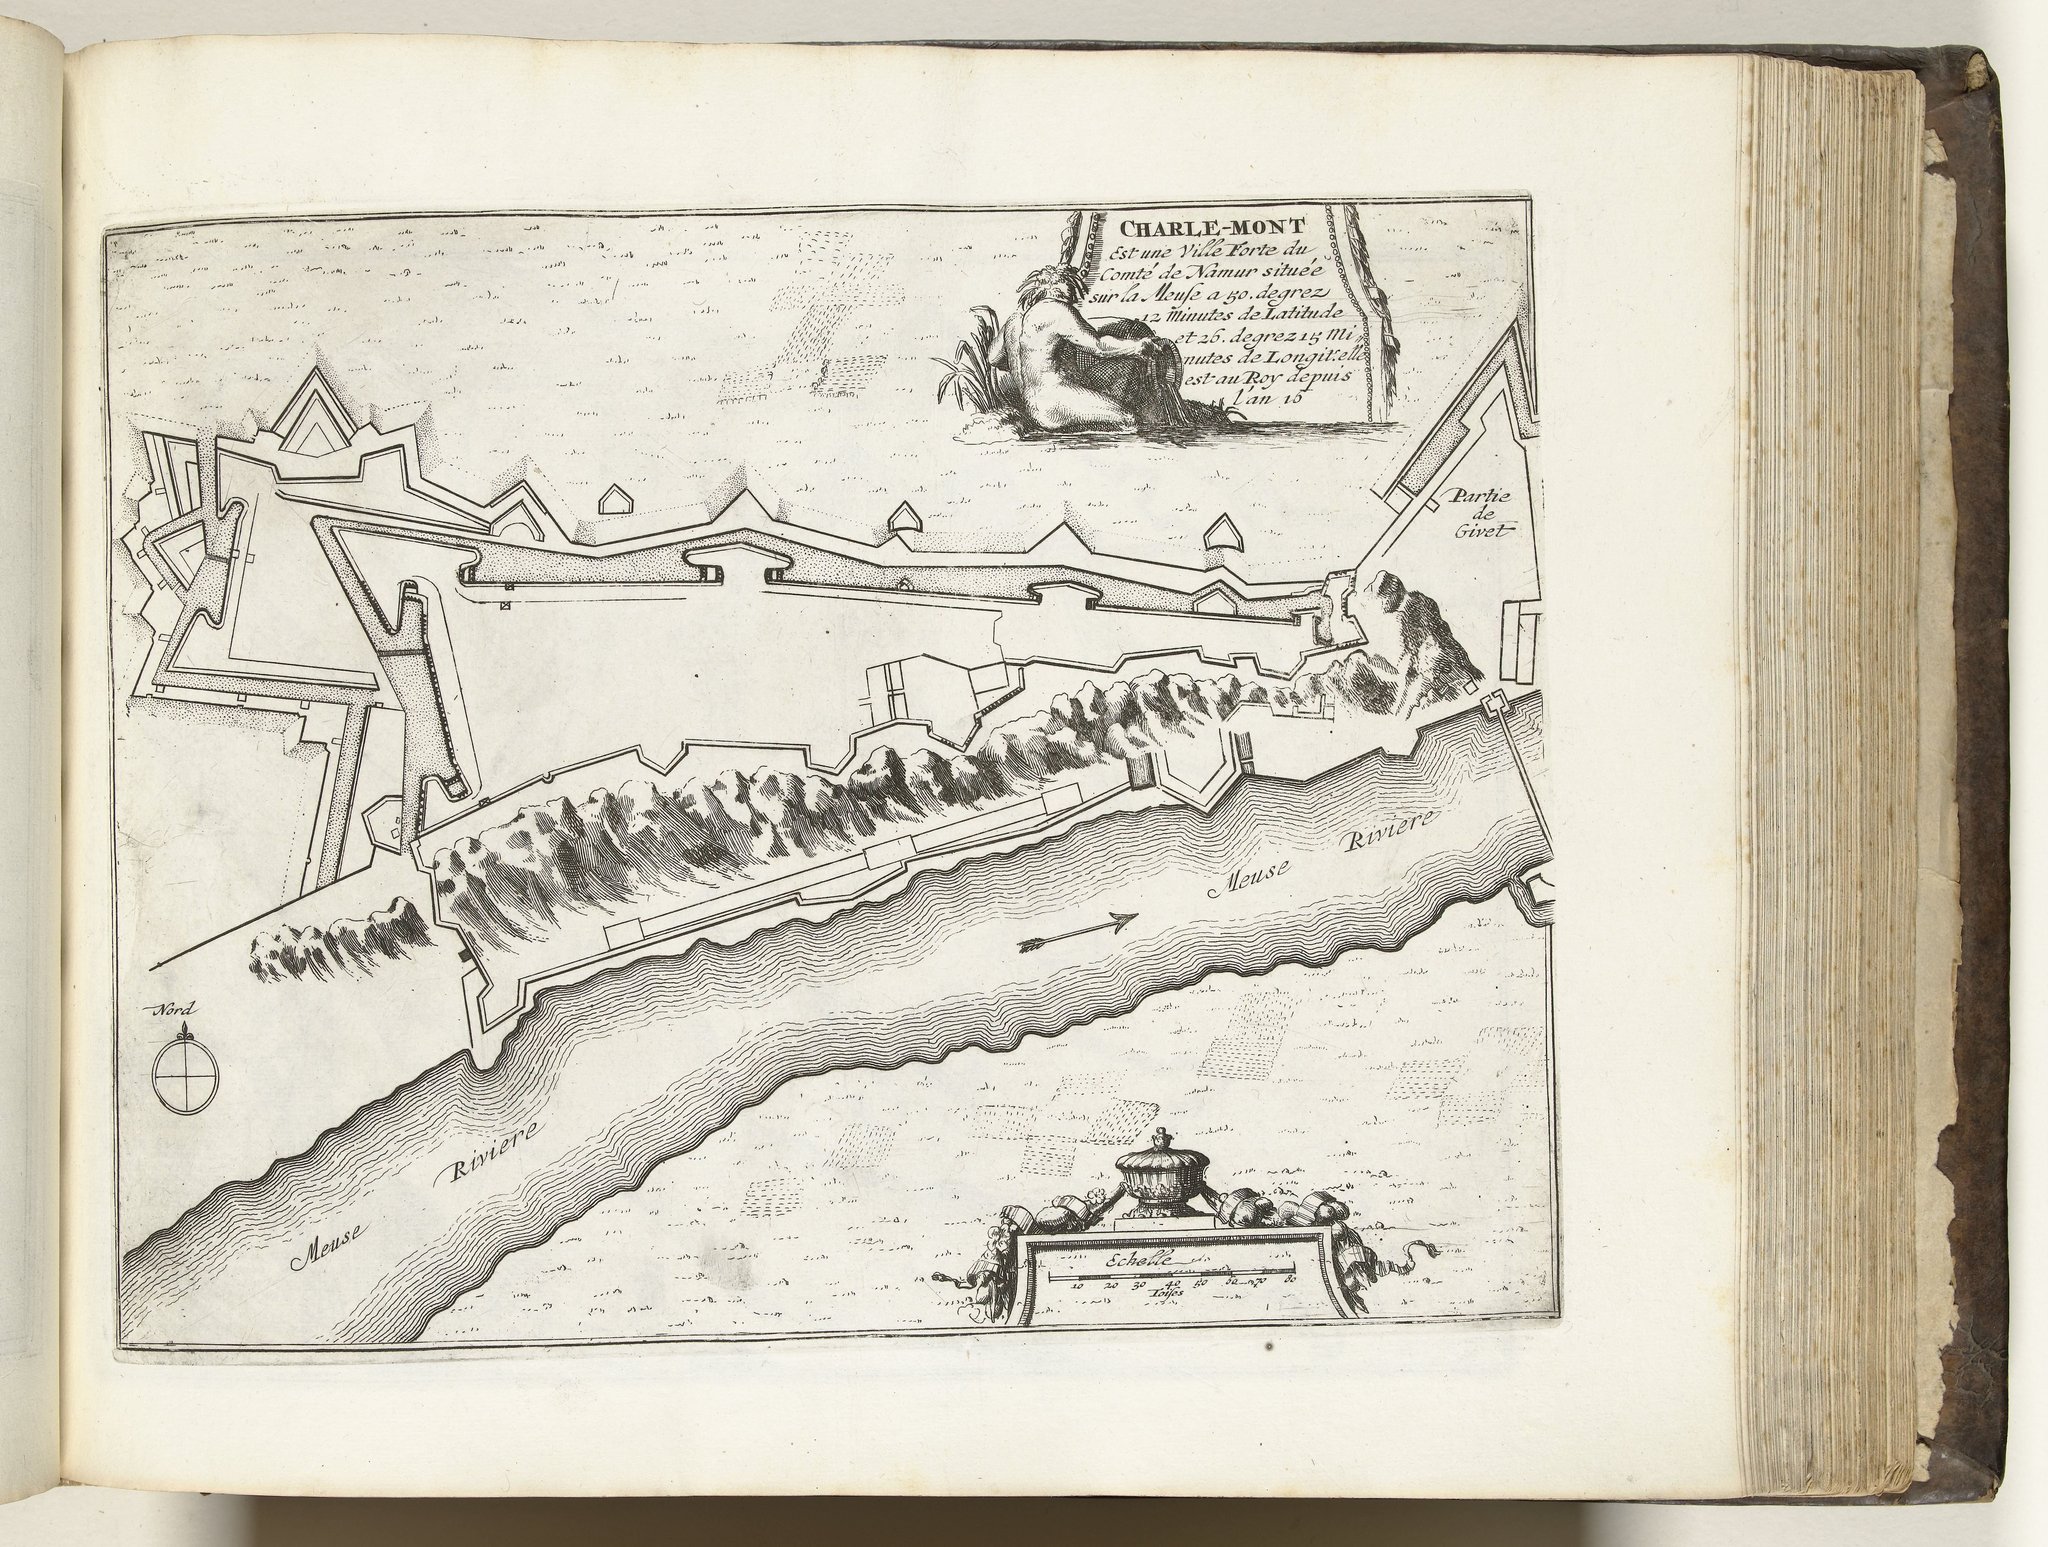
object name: print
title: Les forces de l'Europe, ou description des principales villes, avec leurs fortifications : dessignées par les meilleurs ingenieurs, particulierement celles (...) de la France, dont les plans ont esté levez par M. de Vauban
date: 1693-1696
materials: paper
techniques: etching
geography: france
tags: fortress, maps of cities, namur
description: Plattegrond van de versterkingen om de plaats Charle-Mont, gelegen aan de Maas in de provincie Namen. Onderdeel van het zesde deel (1696) van het prentwerk waarin gebundeld zijn de acht delen van Les forces de l'Europe uitgegeven tussen 1693-1697. Het prentwerk bestaat uit 175 platen met plannen (afkomstig van Sébastien Le Prestre, Seigneur de Vauban) van vermaarde sterke steden en vestingen in de Negenjarige Oorlog. Titel en opschriften in het Frans.